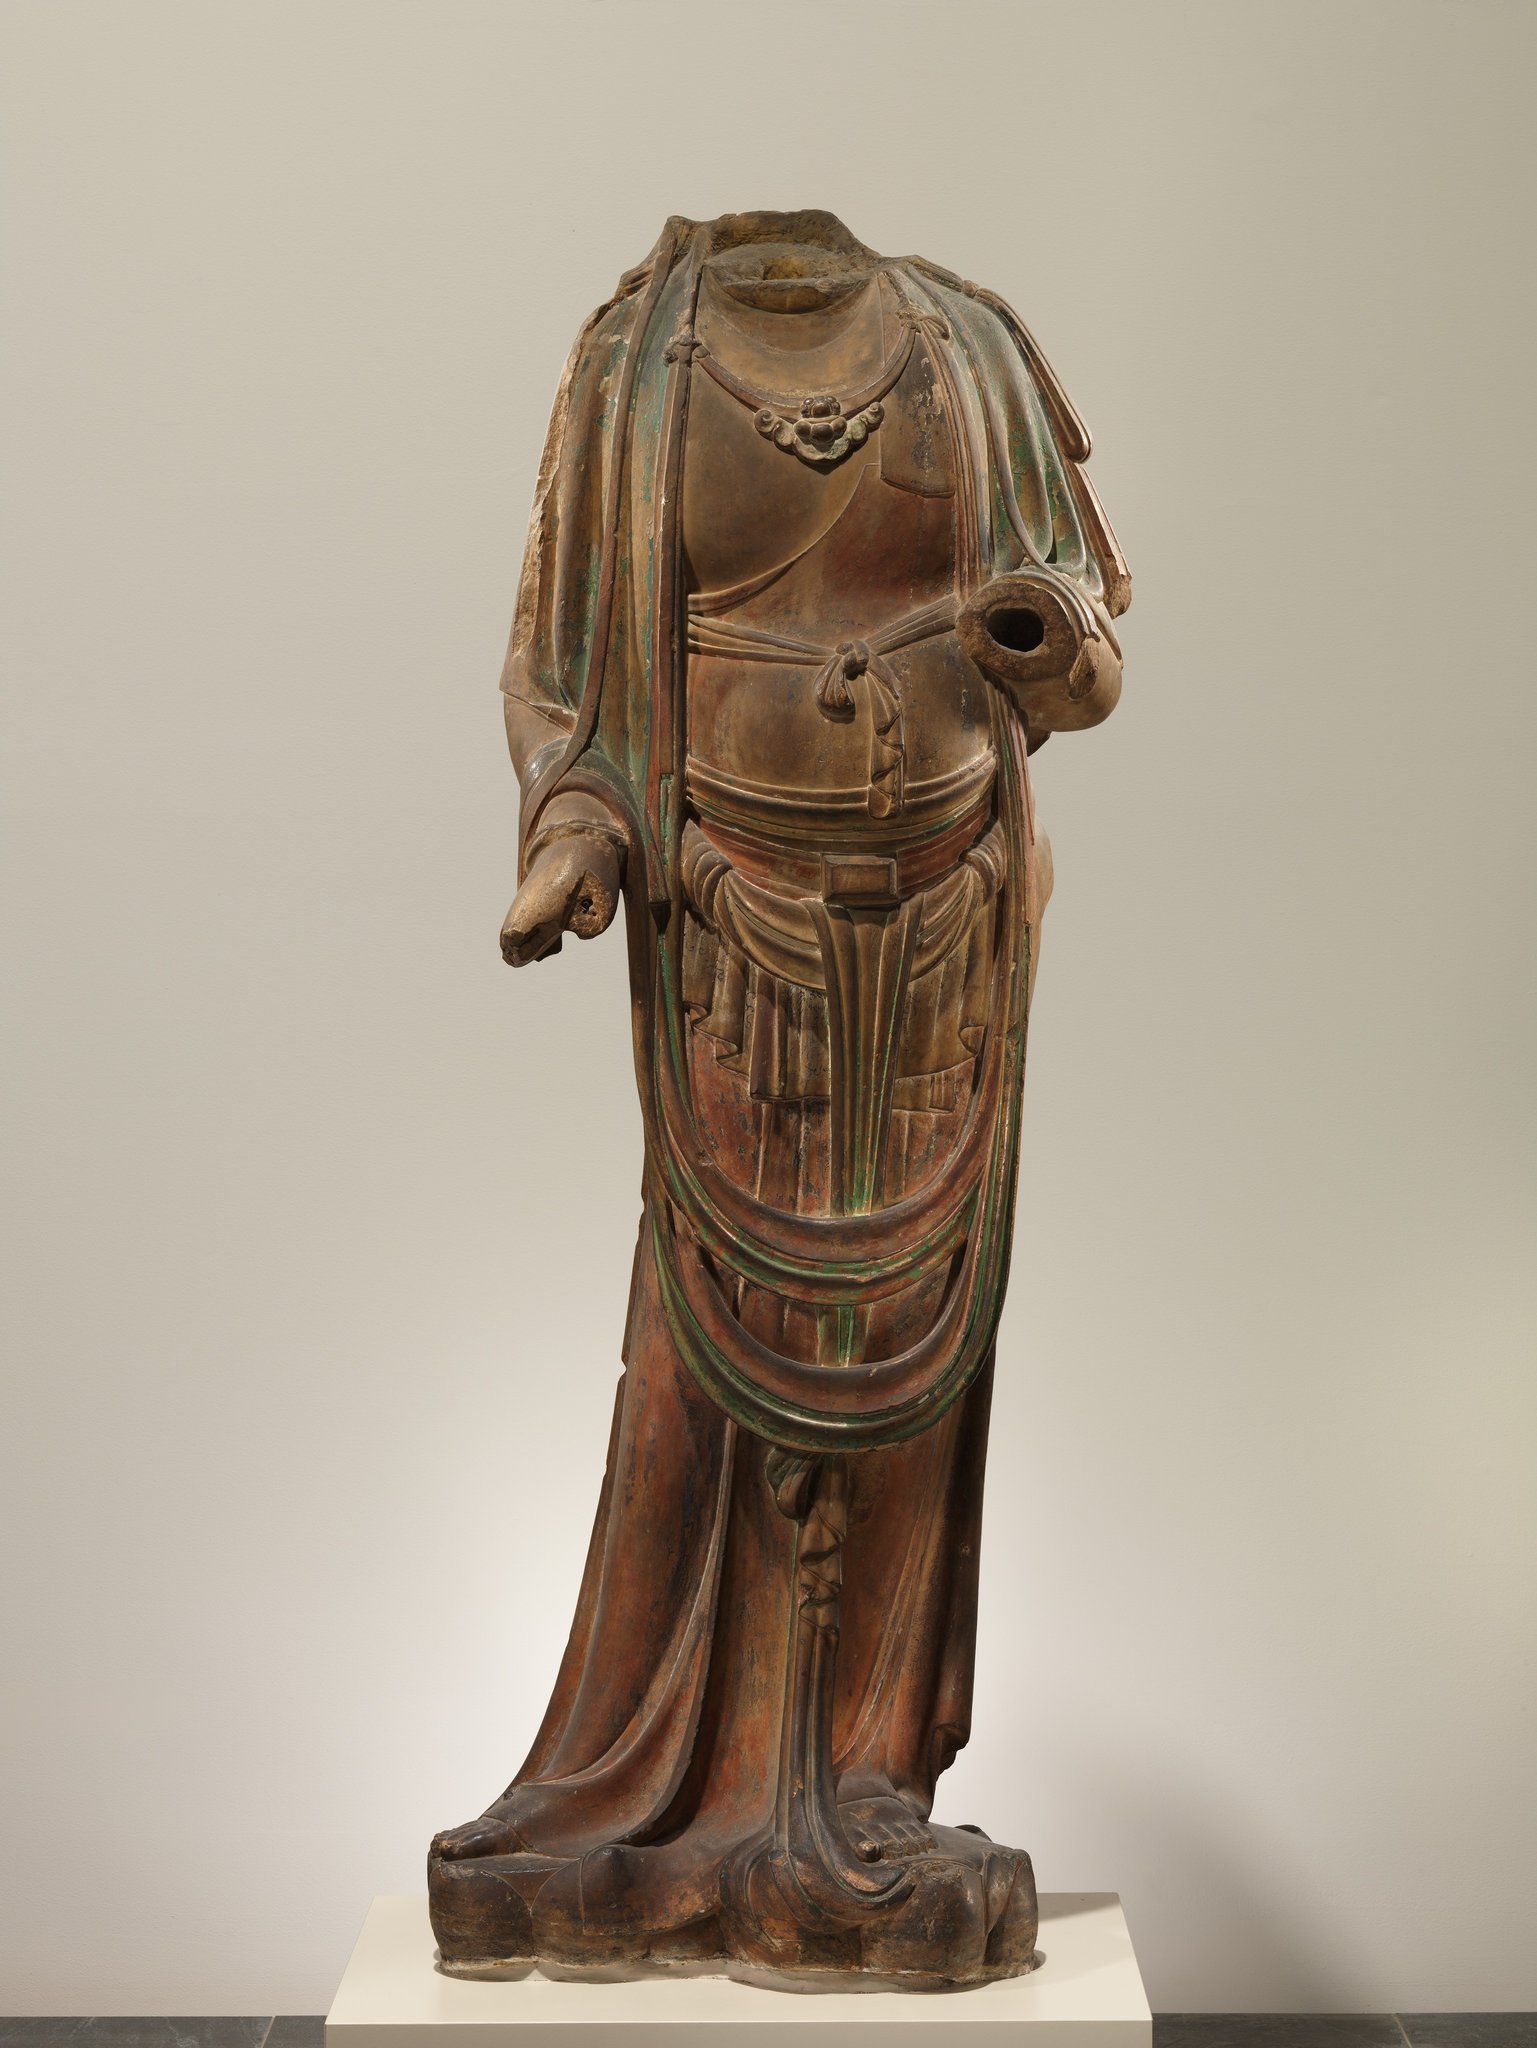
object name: headless figure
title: Bodhisattva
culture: chinese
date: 1101-1300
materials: marble, pigment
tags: bodhisattvas